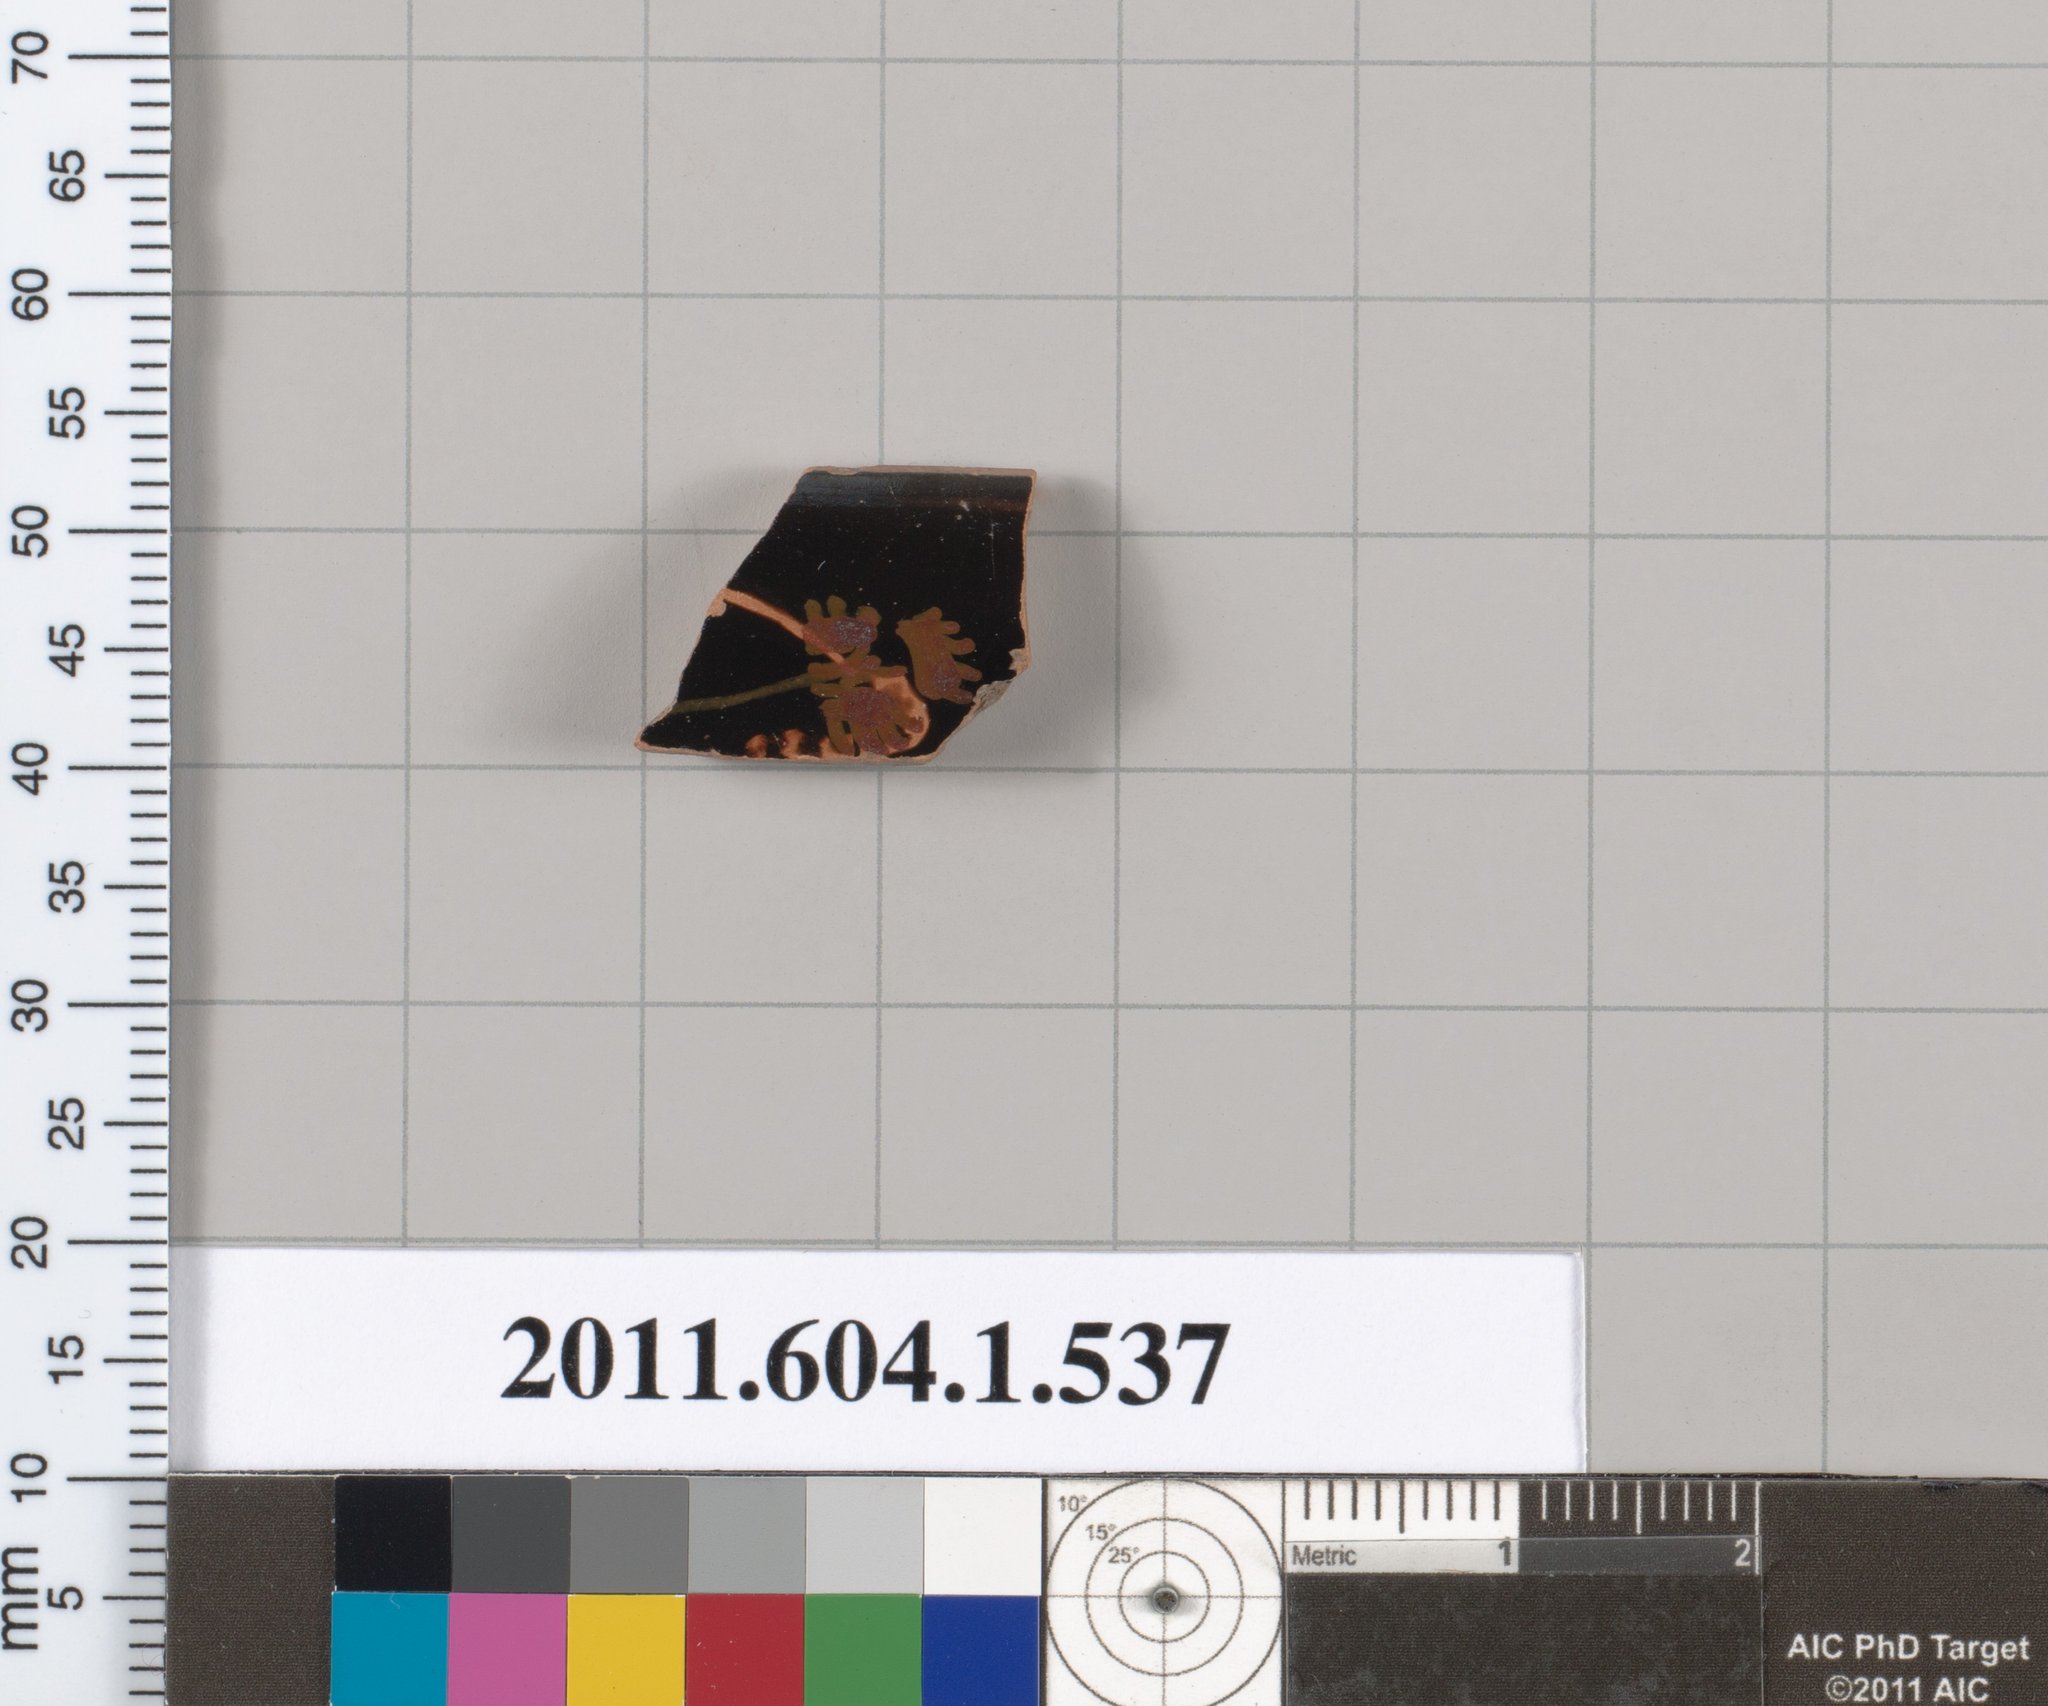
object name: kylix fragment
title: Terracotta rim fragment of a kylix (drinking cup)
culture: greek, attic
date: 480-470 BCE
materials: terracotta